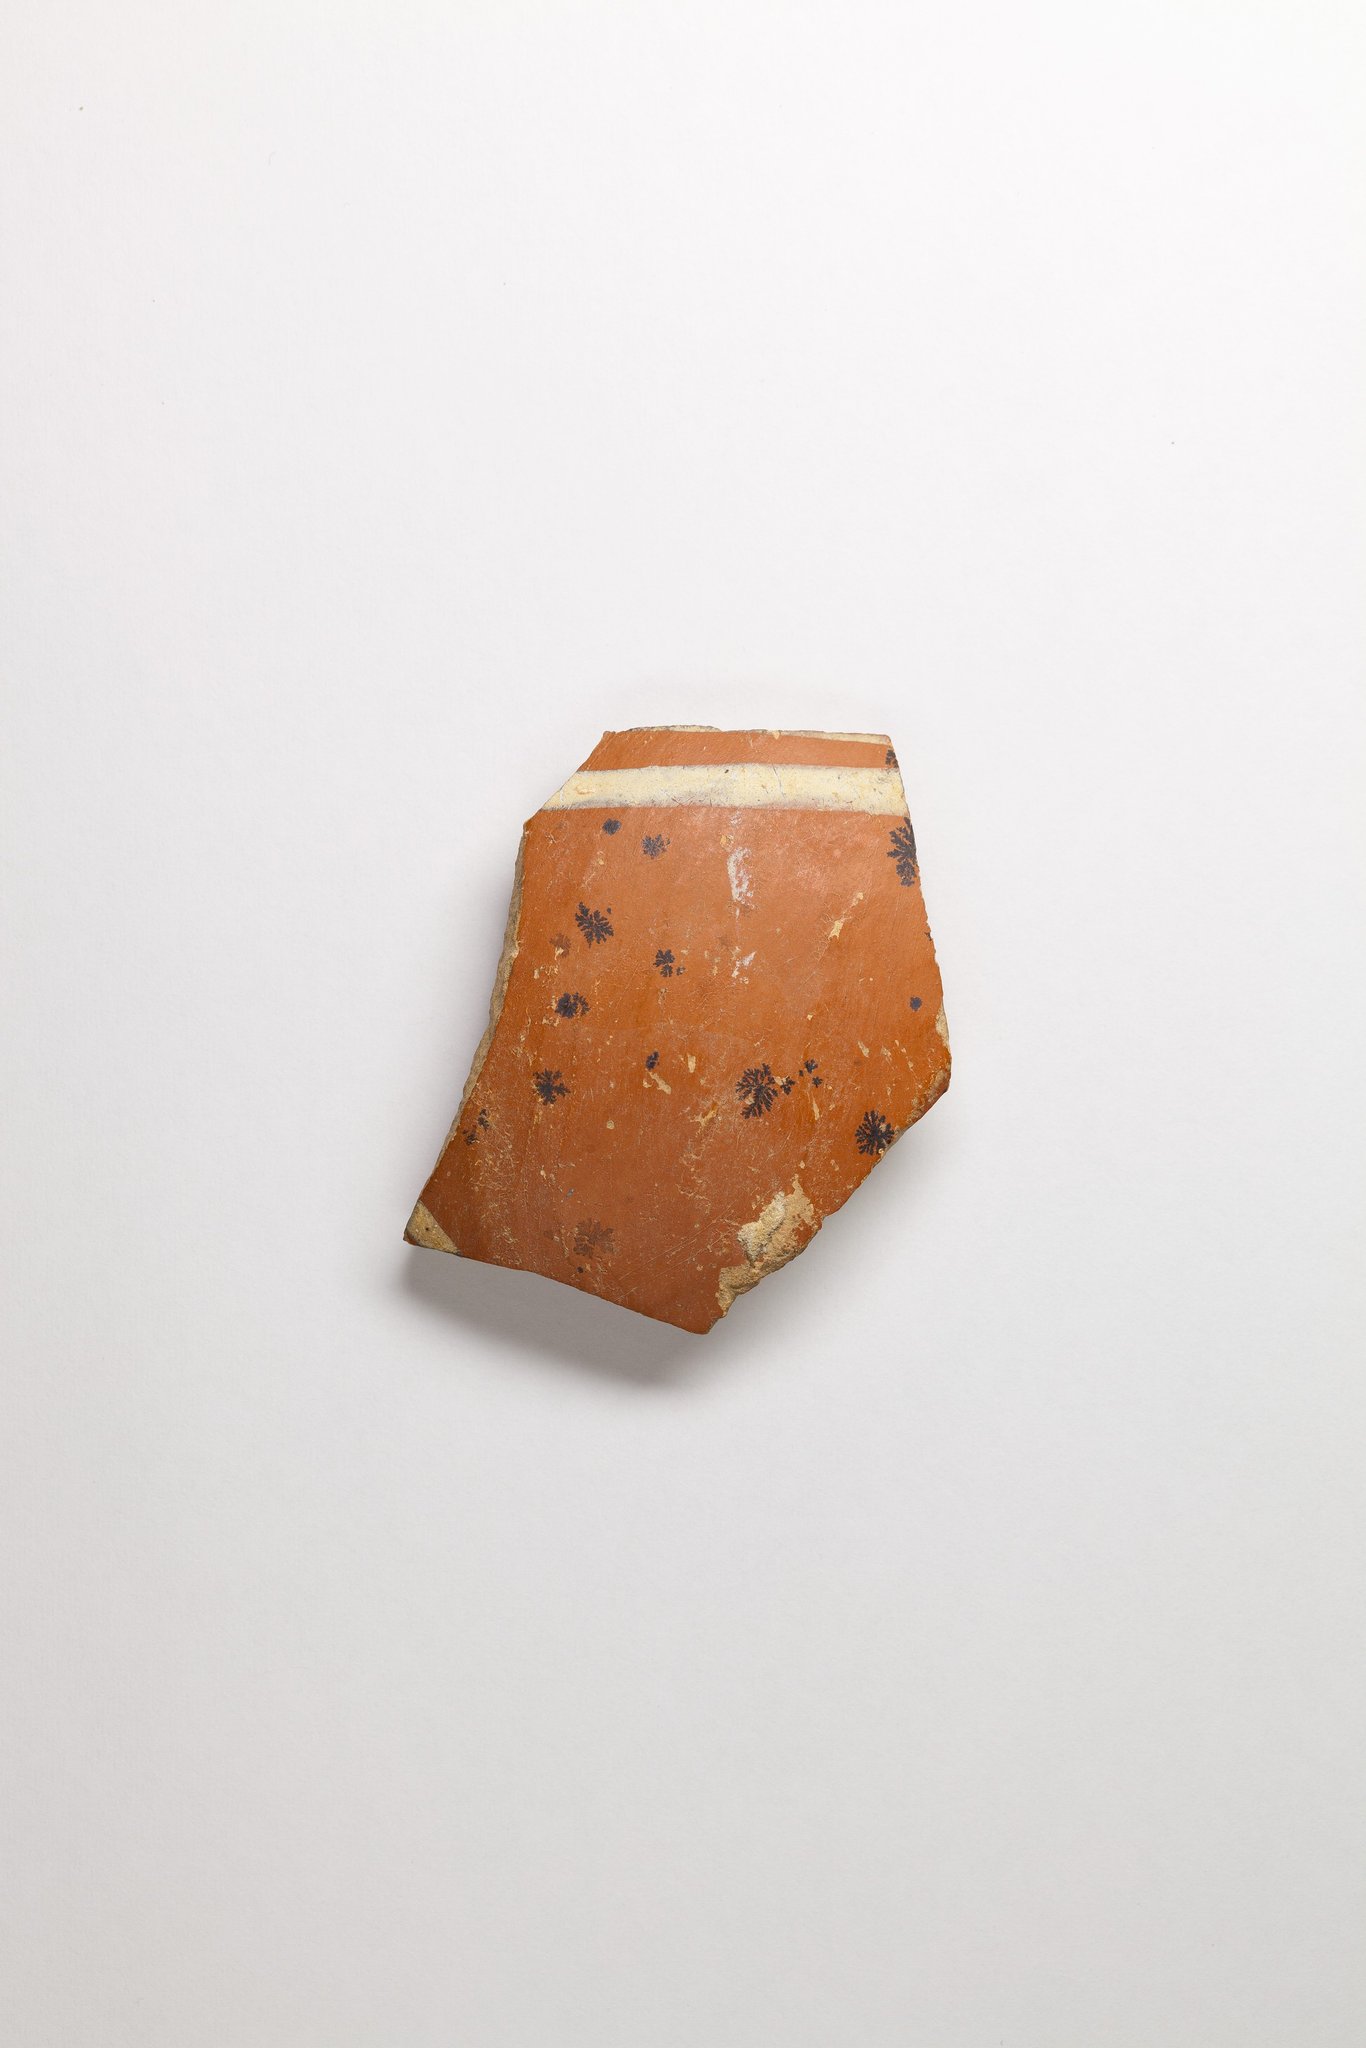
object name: minoan body sherd, bowl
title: Minoan body sherd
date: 1981-1640 BCE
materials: pottery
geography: egypt